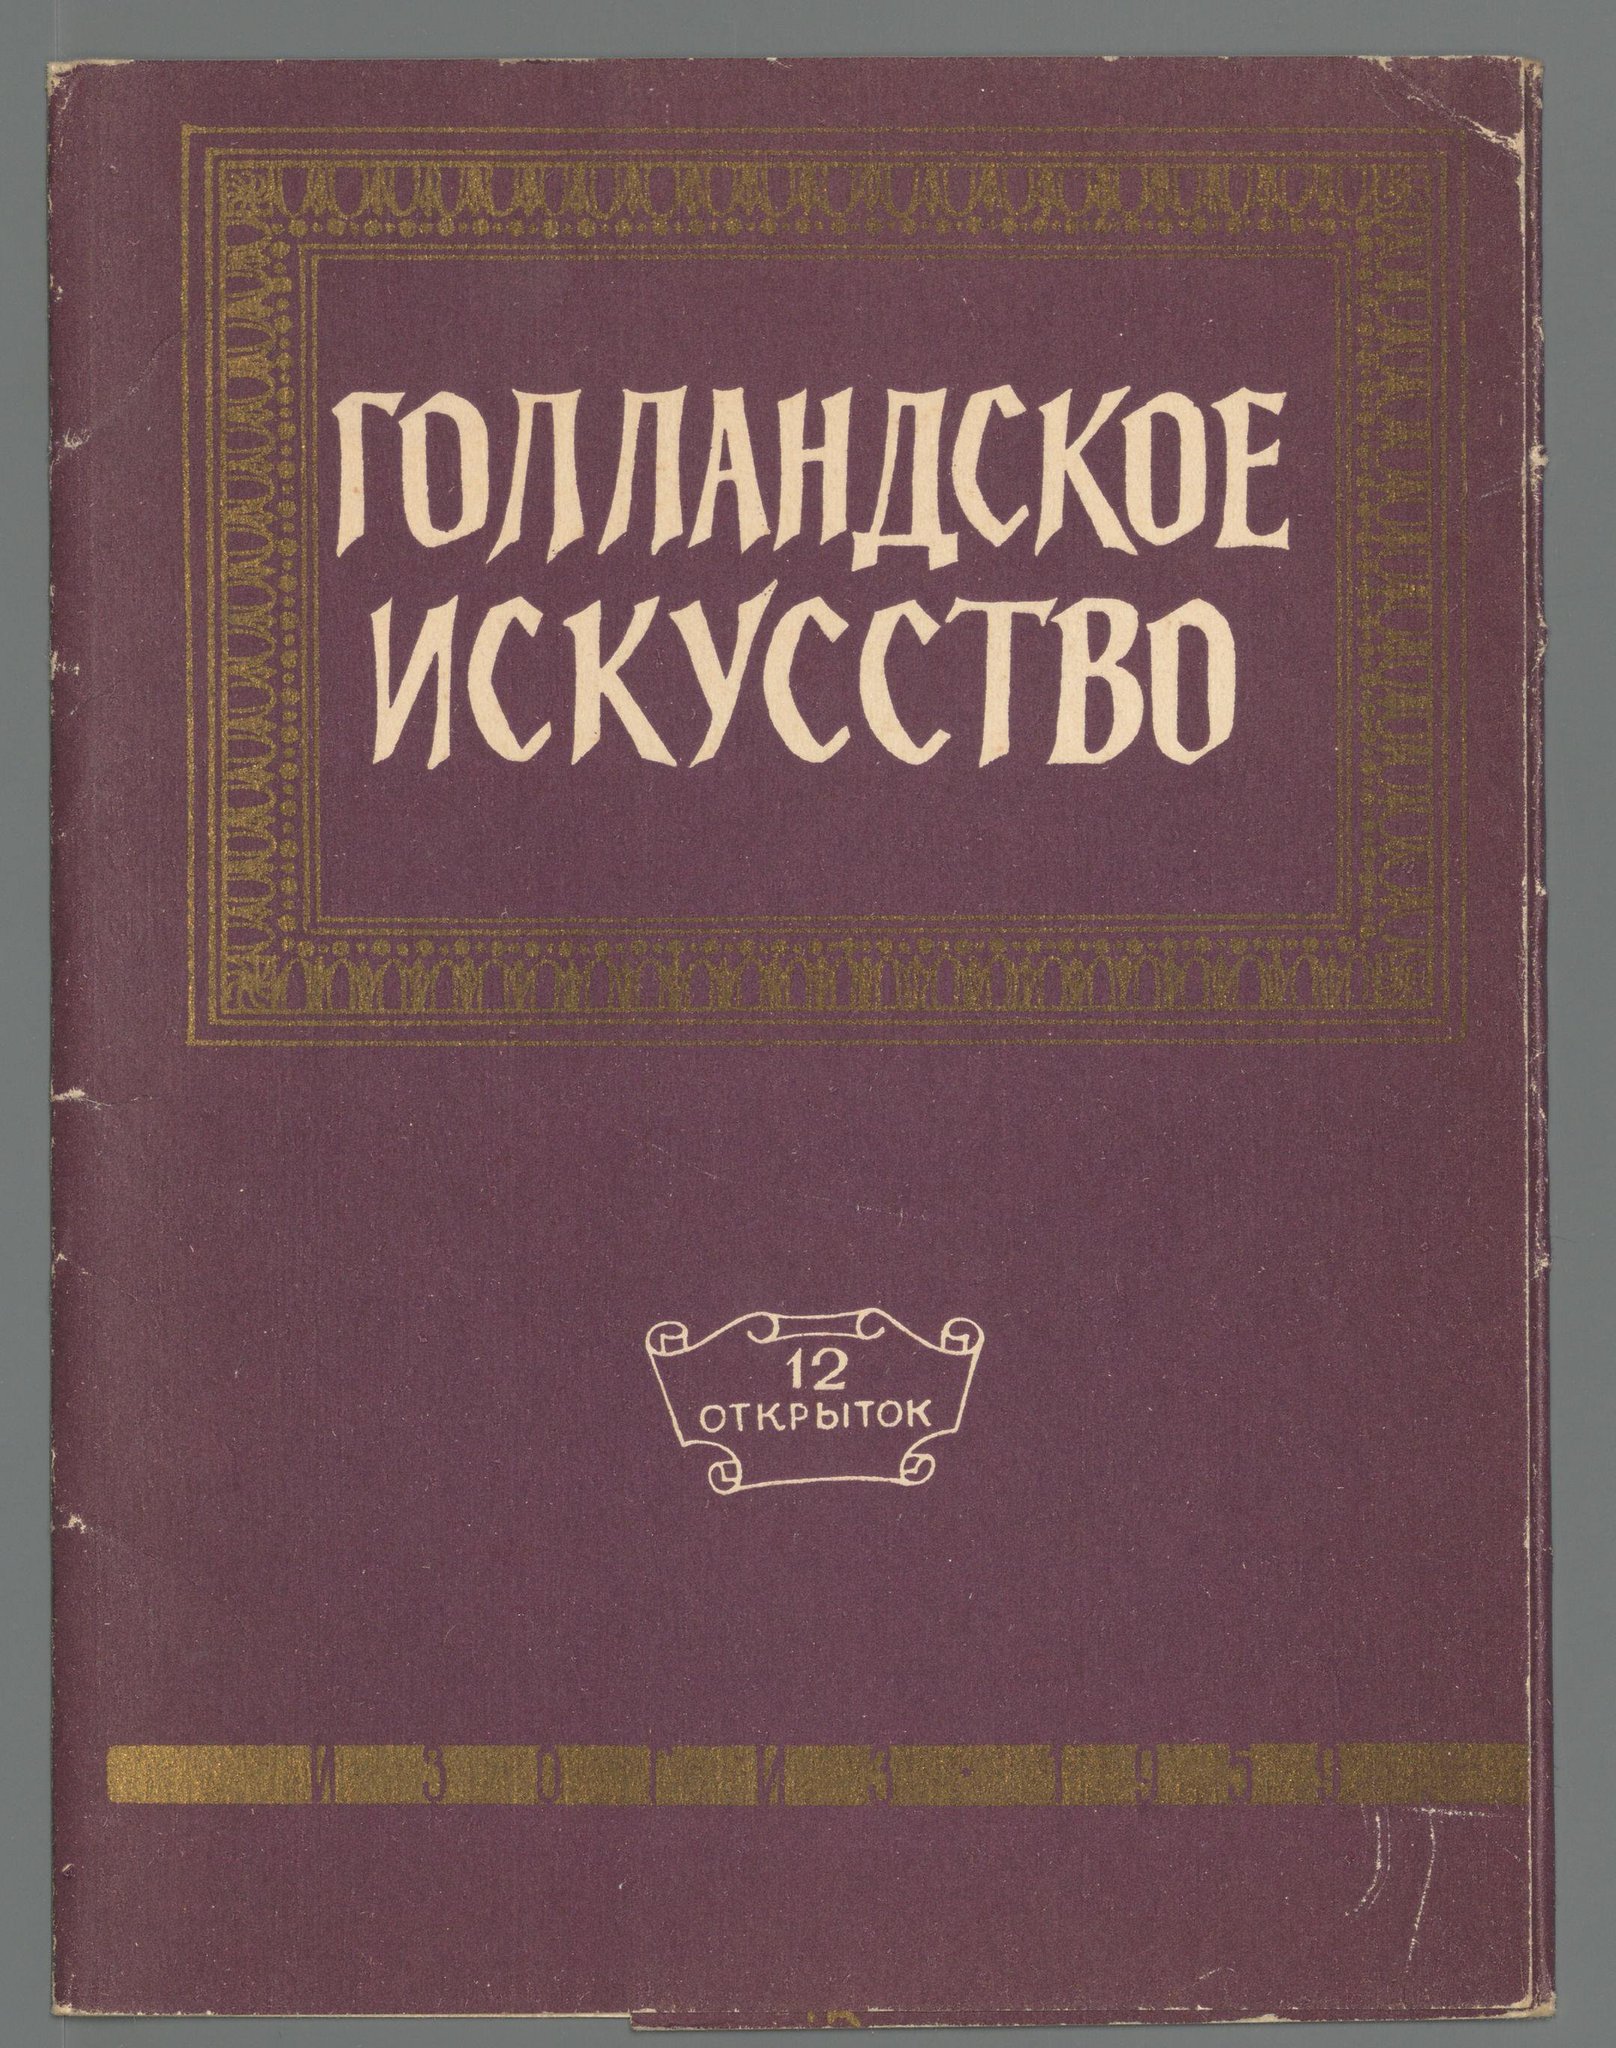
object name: wrapper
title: Omslag voor twaalf prentbriefkaarten met kunstreproducties van Nederlandse schilderijen in de Staats Hermitage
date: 1959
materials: paper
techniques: lithograph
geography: moscow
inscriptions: date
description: In de omslag zit een papier ingestoken met daarop een beschrijving van de inhoud.